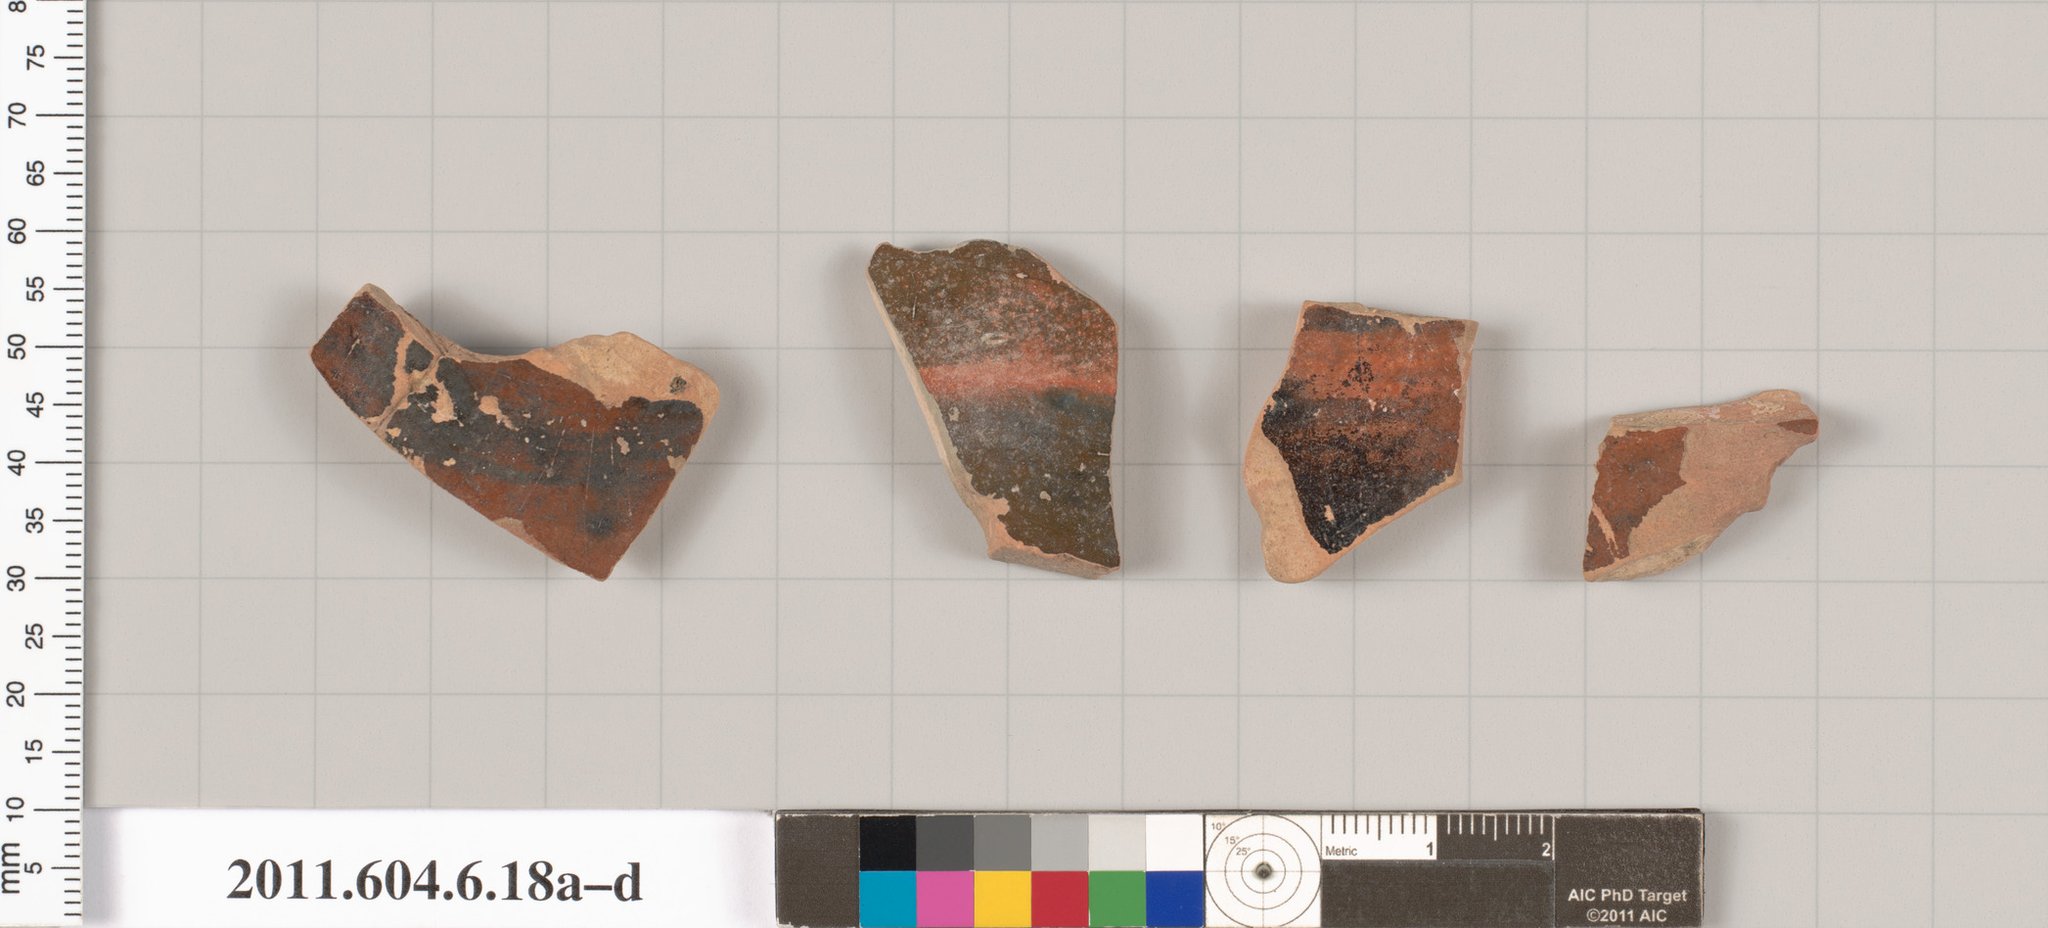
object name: undetermined open shape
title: Terracotta fragments of open shapes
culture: greek, attic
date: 600-401 BCE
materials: terracotta